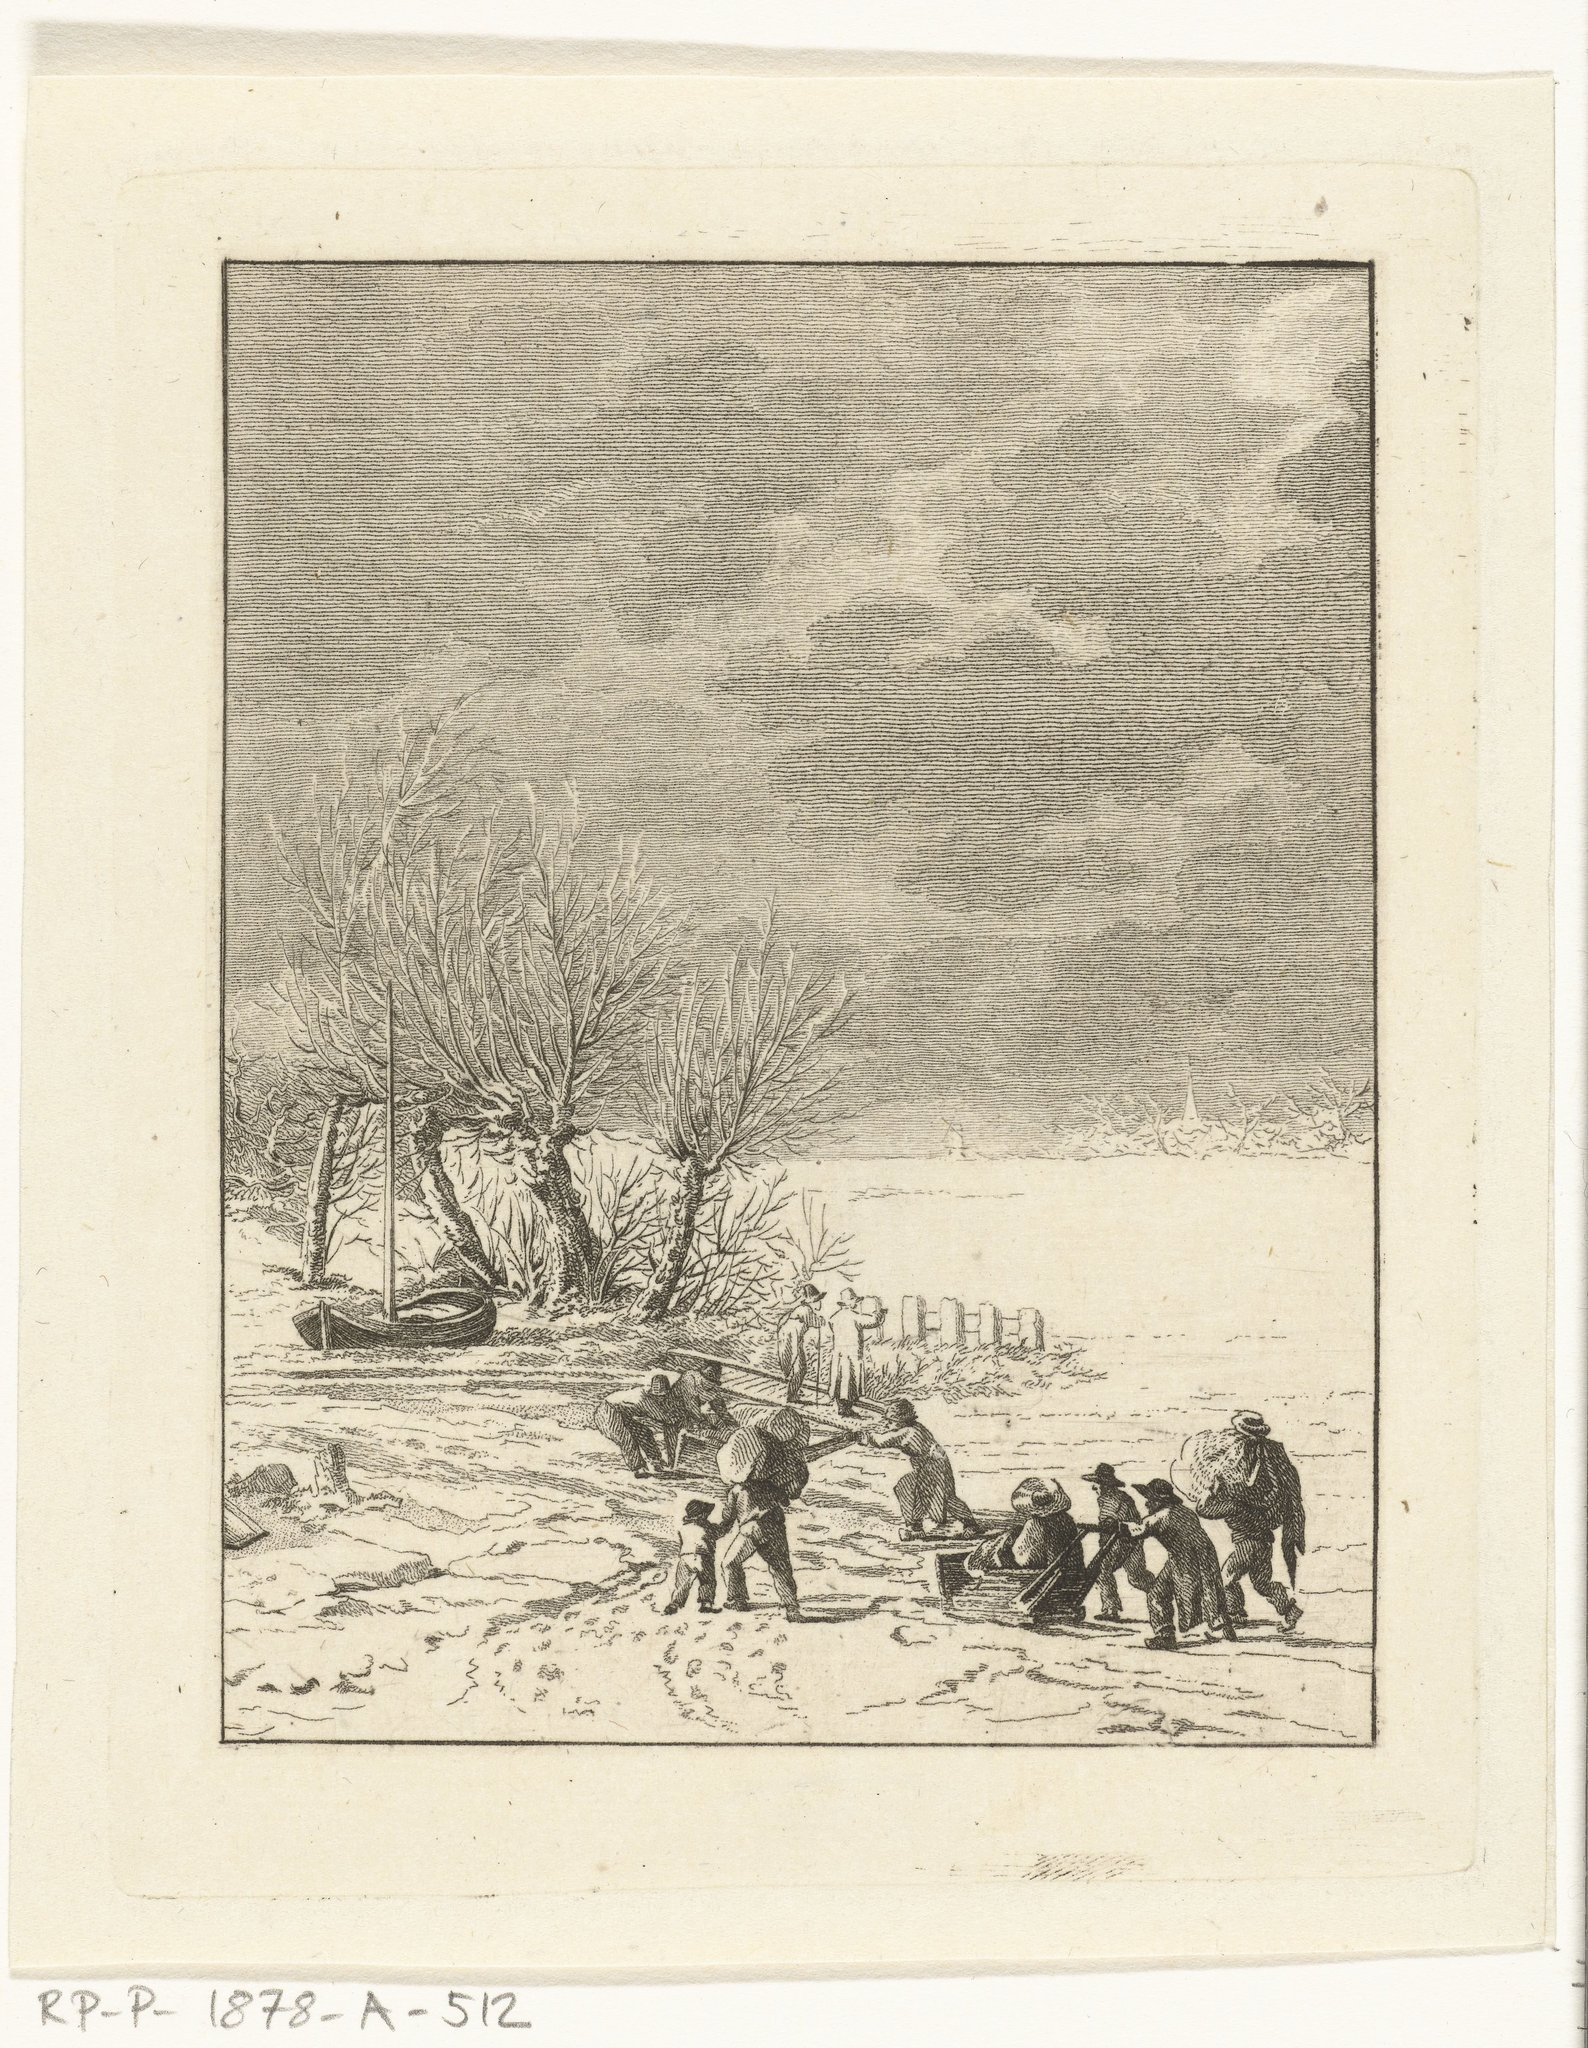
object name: print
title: Bevroren rivier met sleeënde kinderen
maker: joannes bemme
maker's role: print maker, printer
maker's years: 1775-1841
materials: paper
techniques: etching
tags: winter landscape; landscape symbolizing winter (the four seasons of the year), sliding (playing with snow and ice)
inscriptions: collector's mark: Lugt 2228